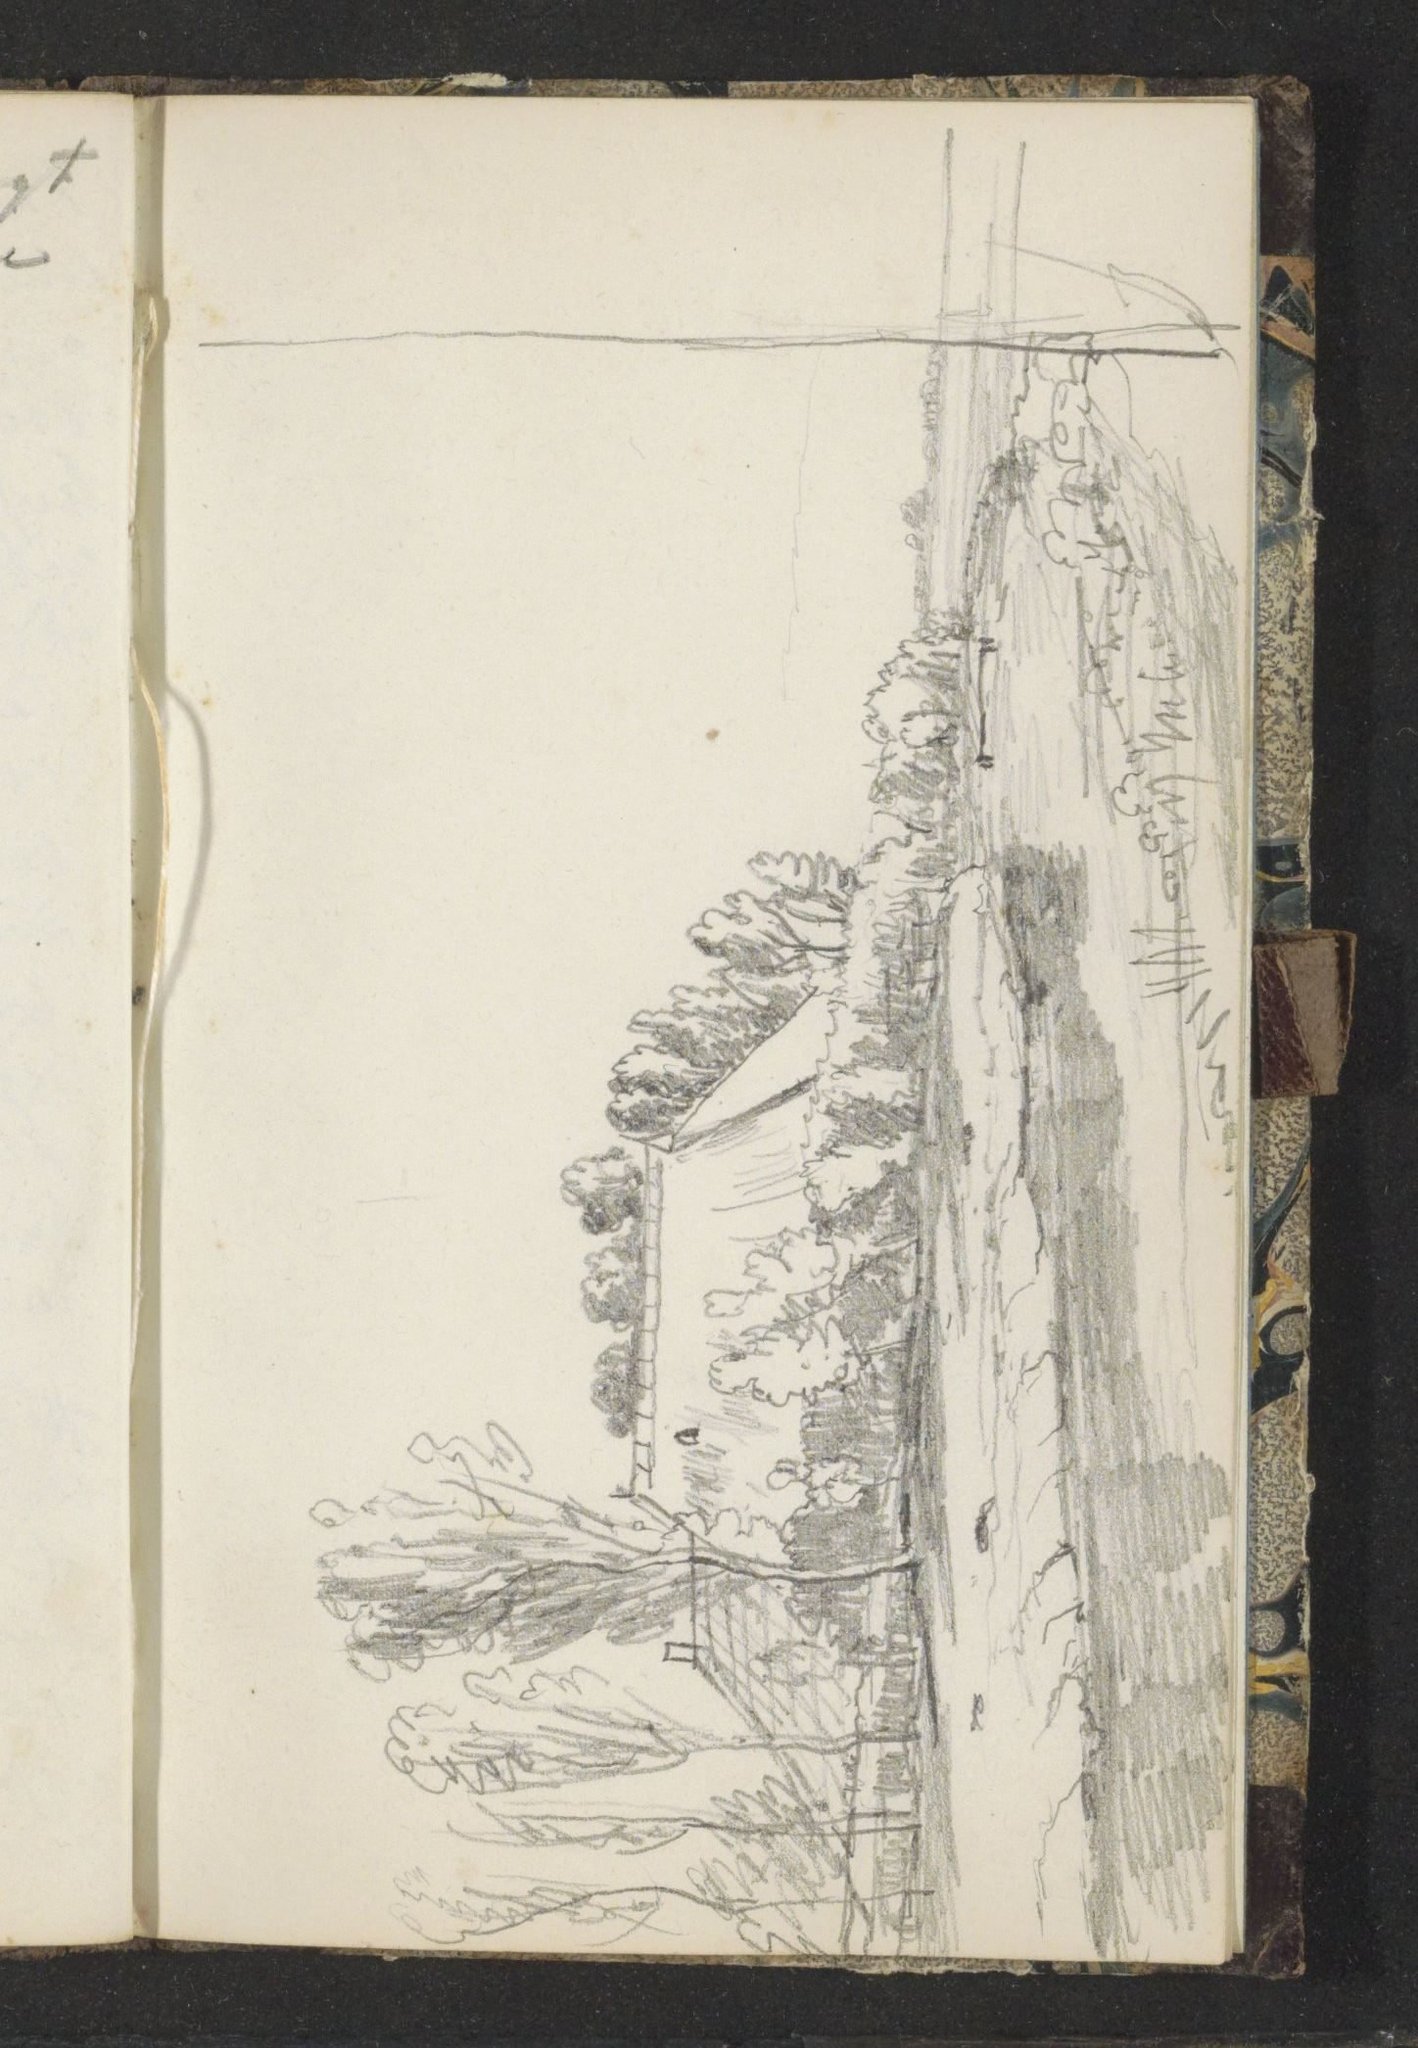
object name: sketchbook leaf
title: Landschap met een boerderij bij een sloot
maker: Anonymous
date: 1802-1874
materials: paper, pencil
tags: small canal, ditch, farm (building)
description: Blad 17 recto uit een schetsboek met 19 bladen.